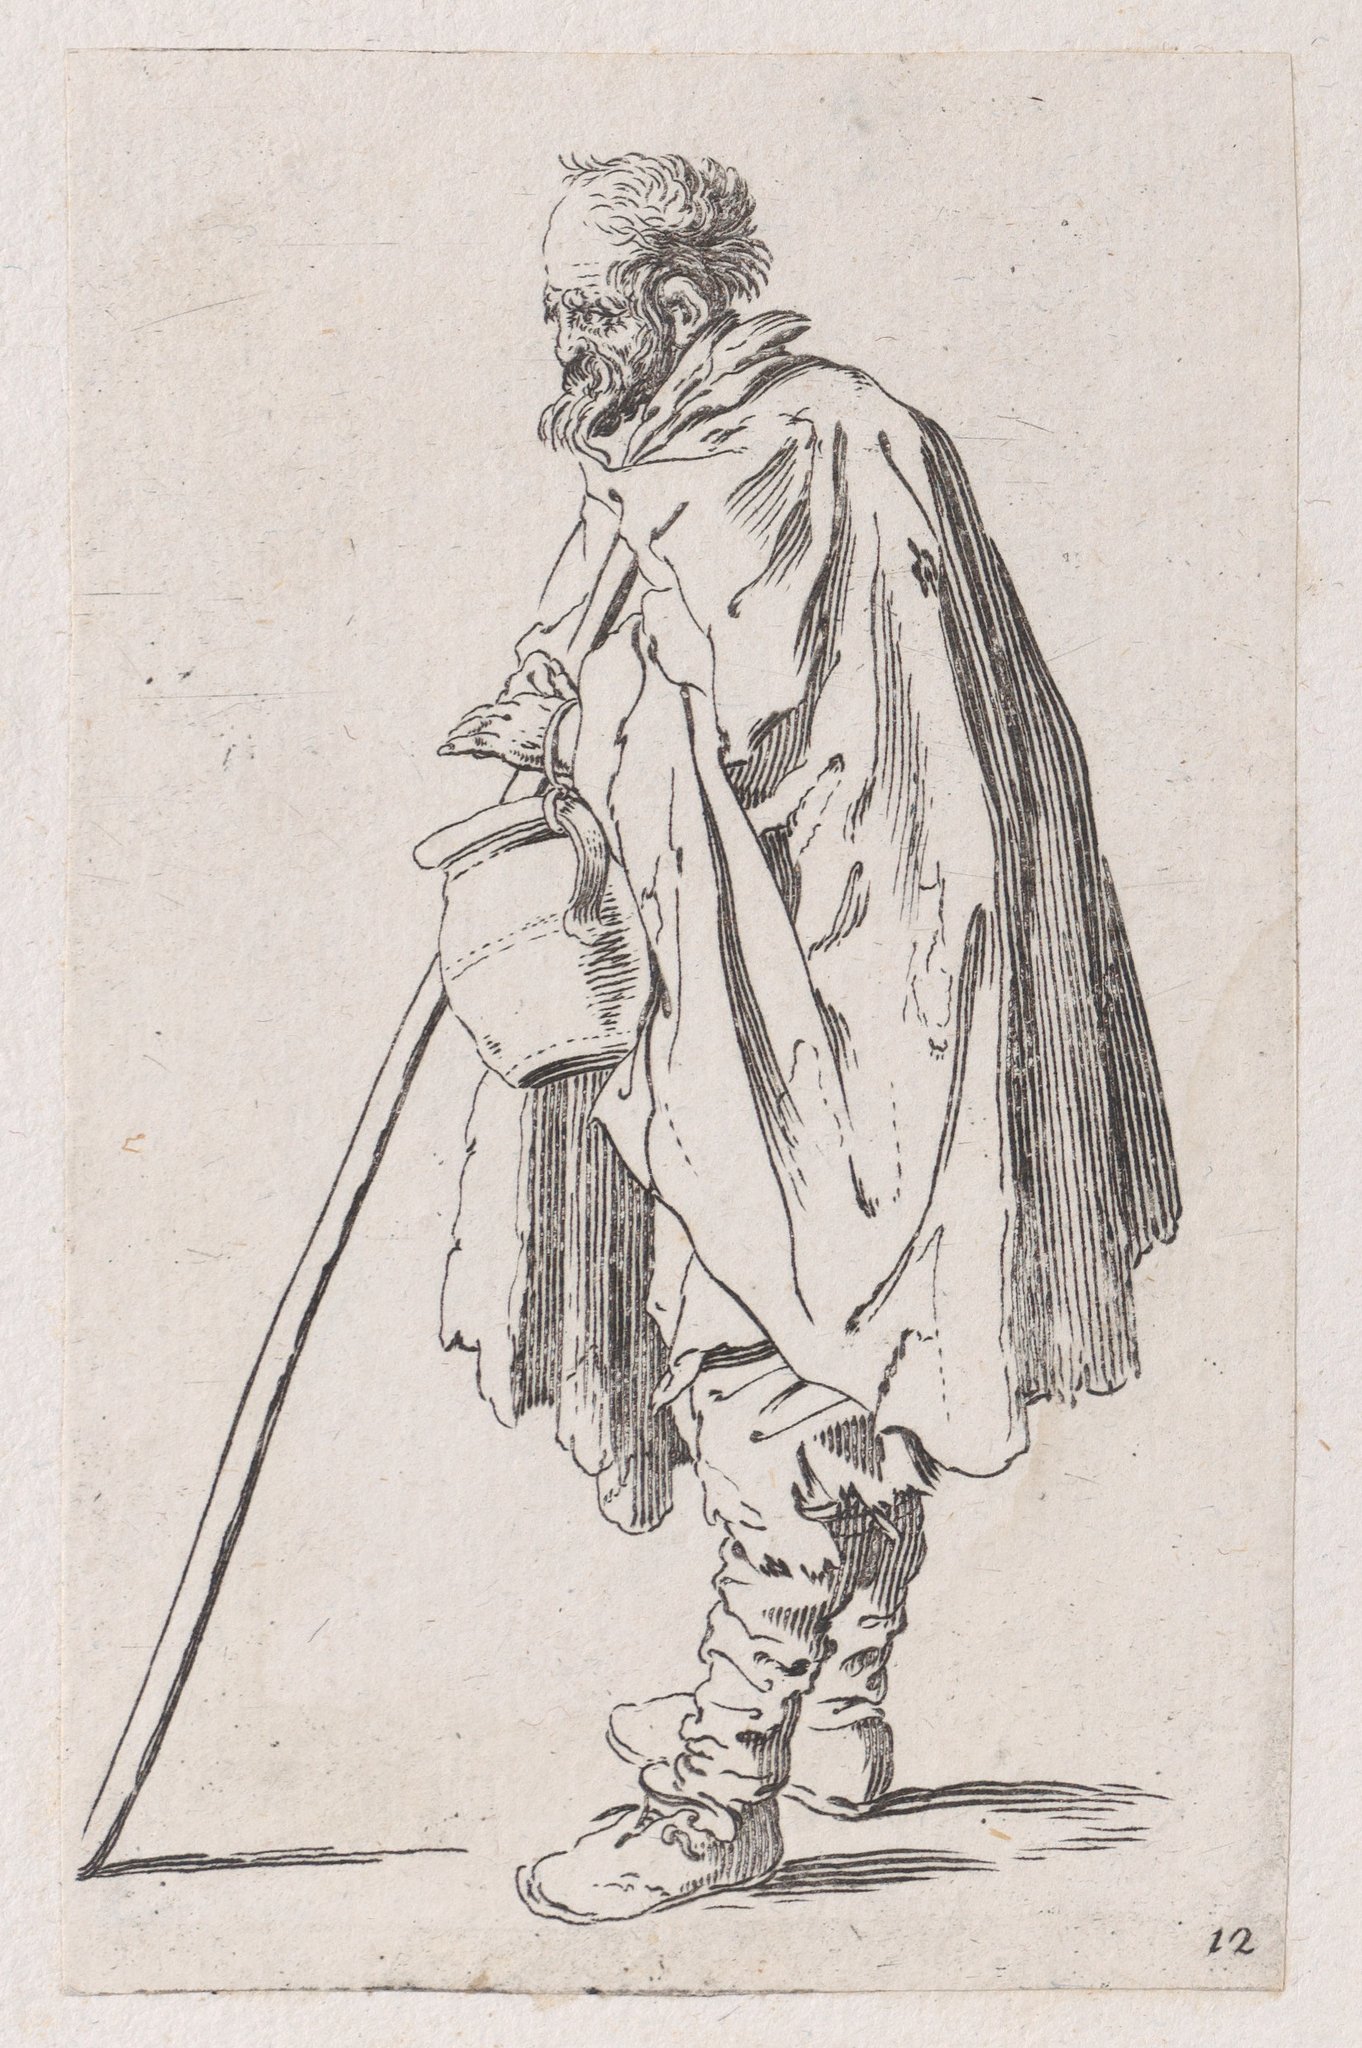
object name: print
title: Reverse Copy of Le Mendiant au Couvet (The Beggar of Couvet), from Les Gueux suite appelée aussi Les Mendiants, Les Baroni, ou Les Barons (The Beggars, also called the Barons)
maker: Anonymous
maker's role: artist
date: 1601-1700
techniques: etching